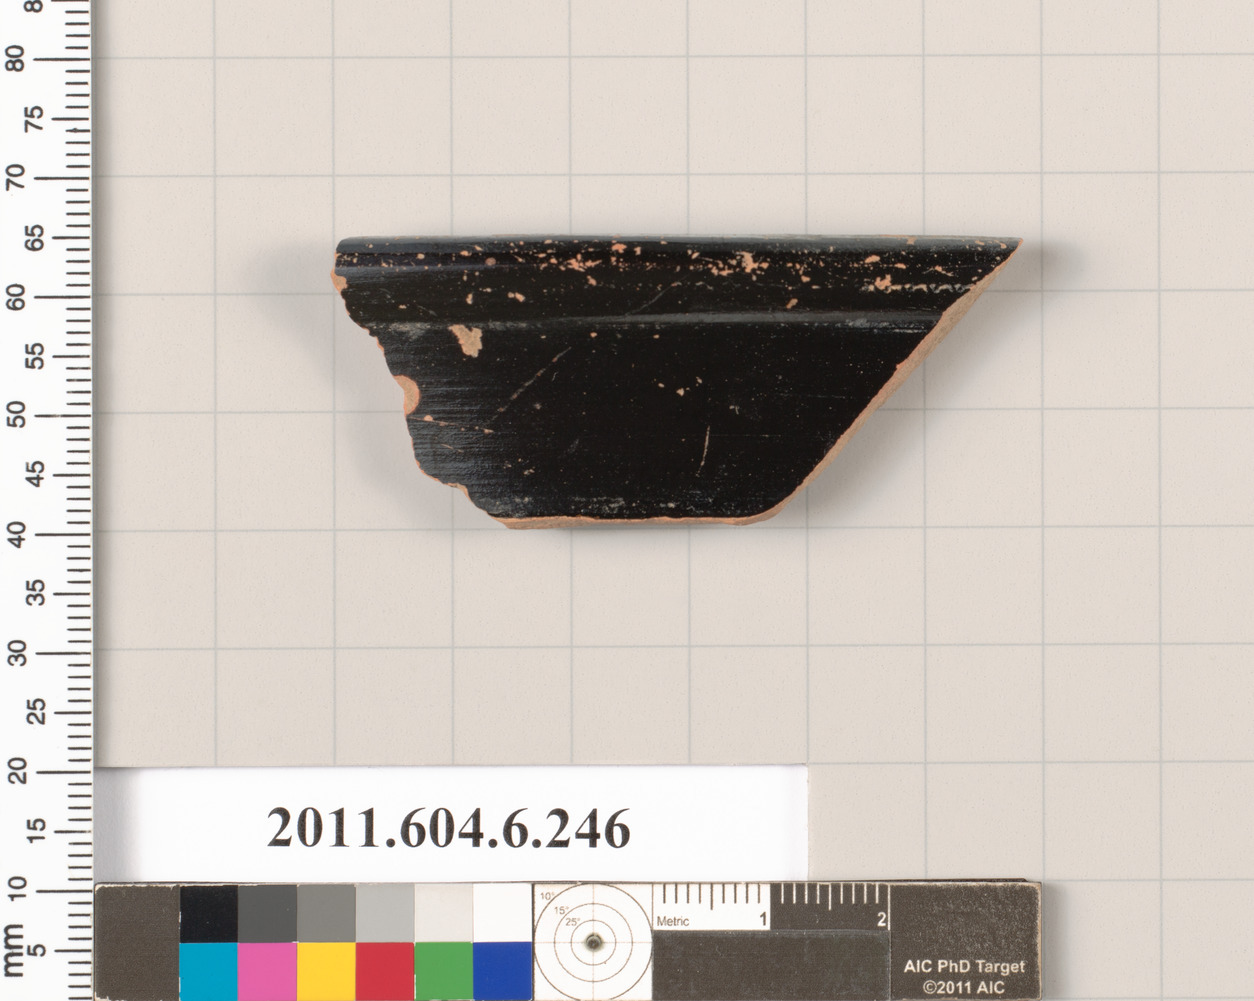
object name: undetermined open shape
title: Terracotta rim fragment of an open shape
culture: greek, attic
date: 600-301 BCE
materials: terracotta